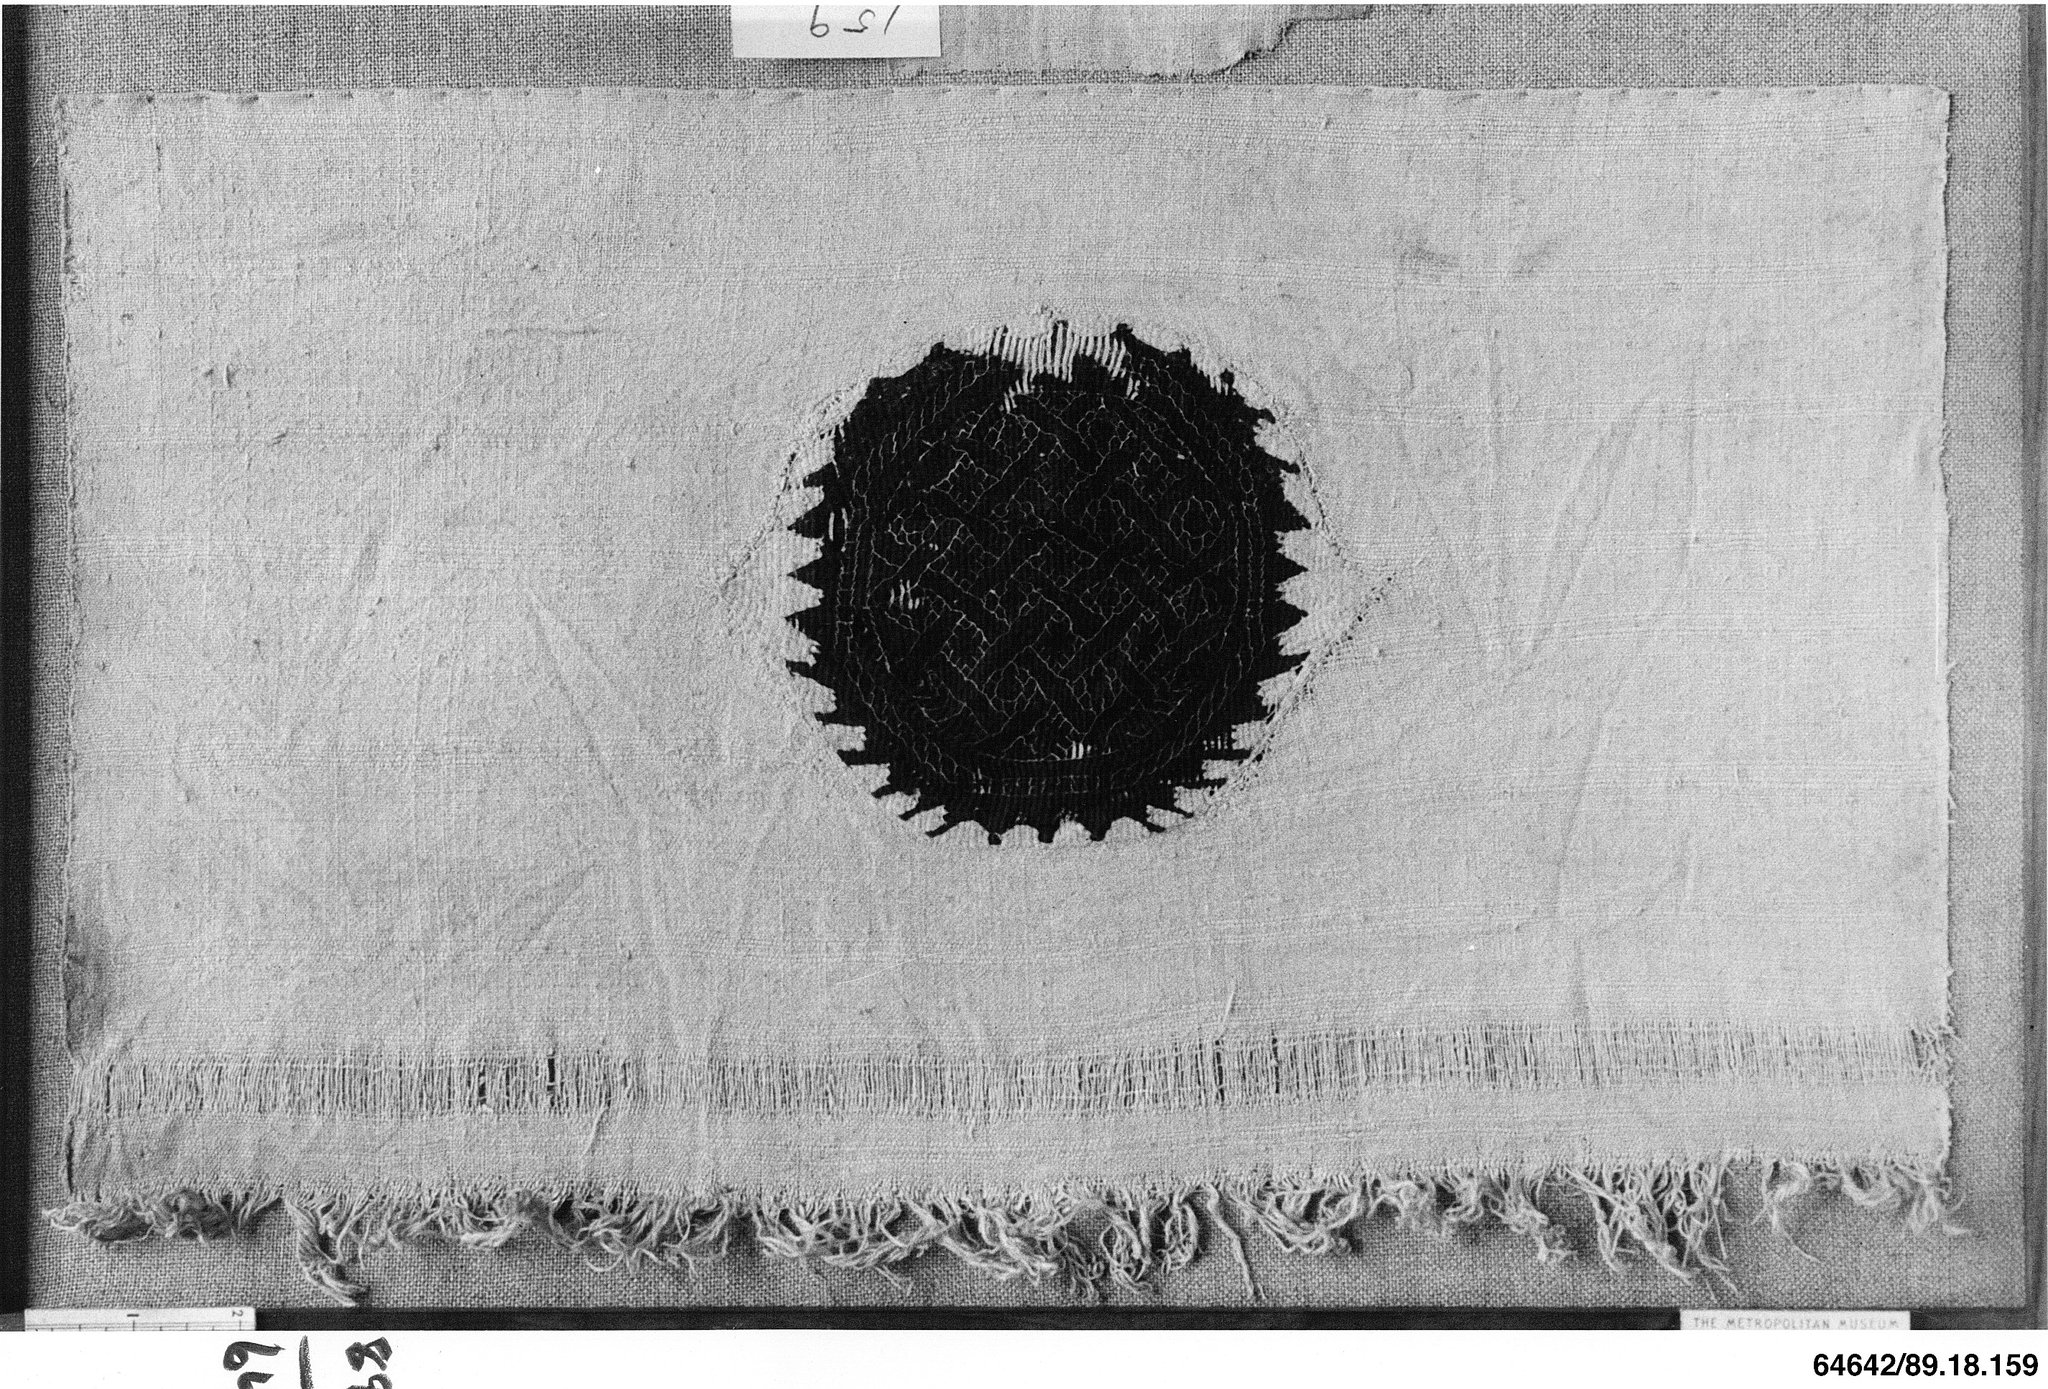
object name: textile fragment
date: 201-400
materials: linen, wool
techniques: weave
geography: egypt